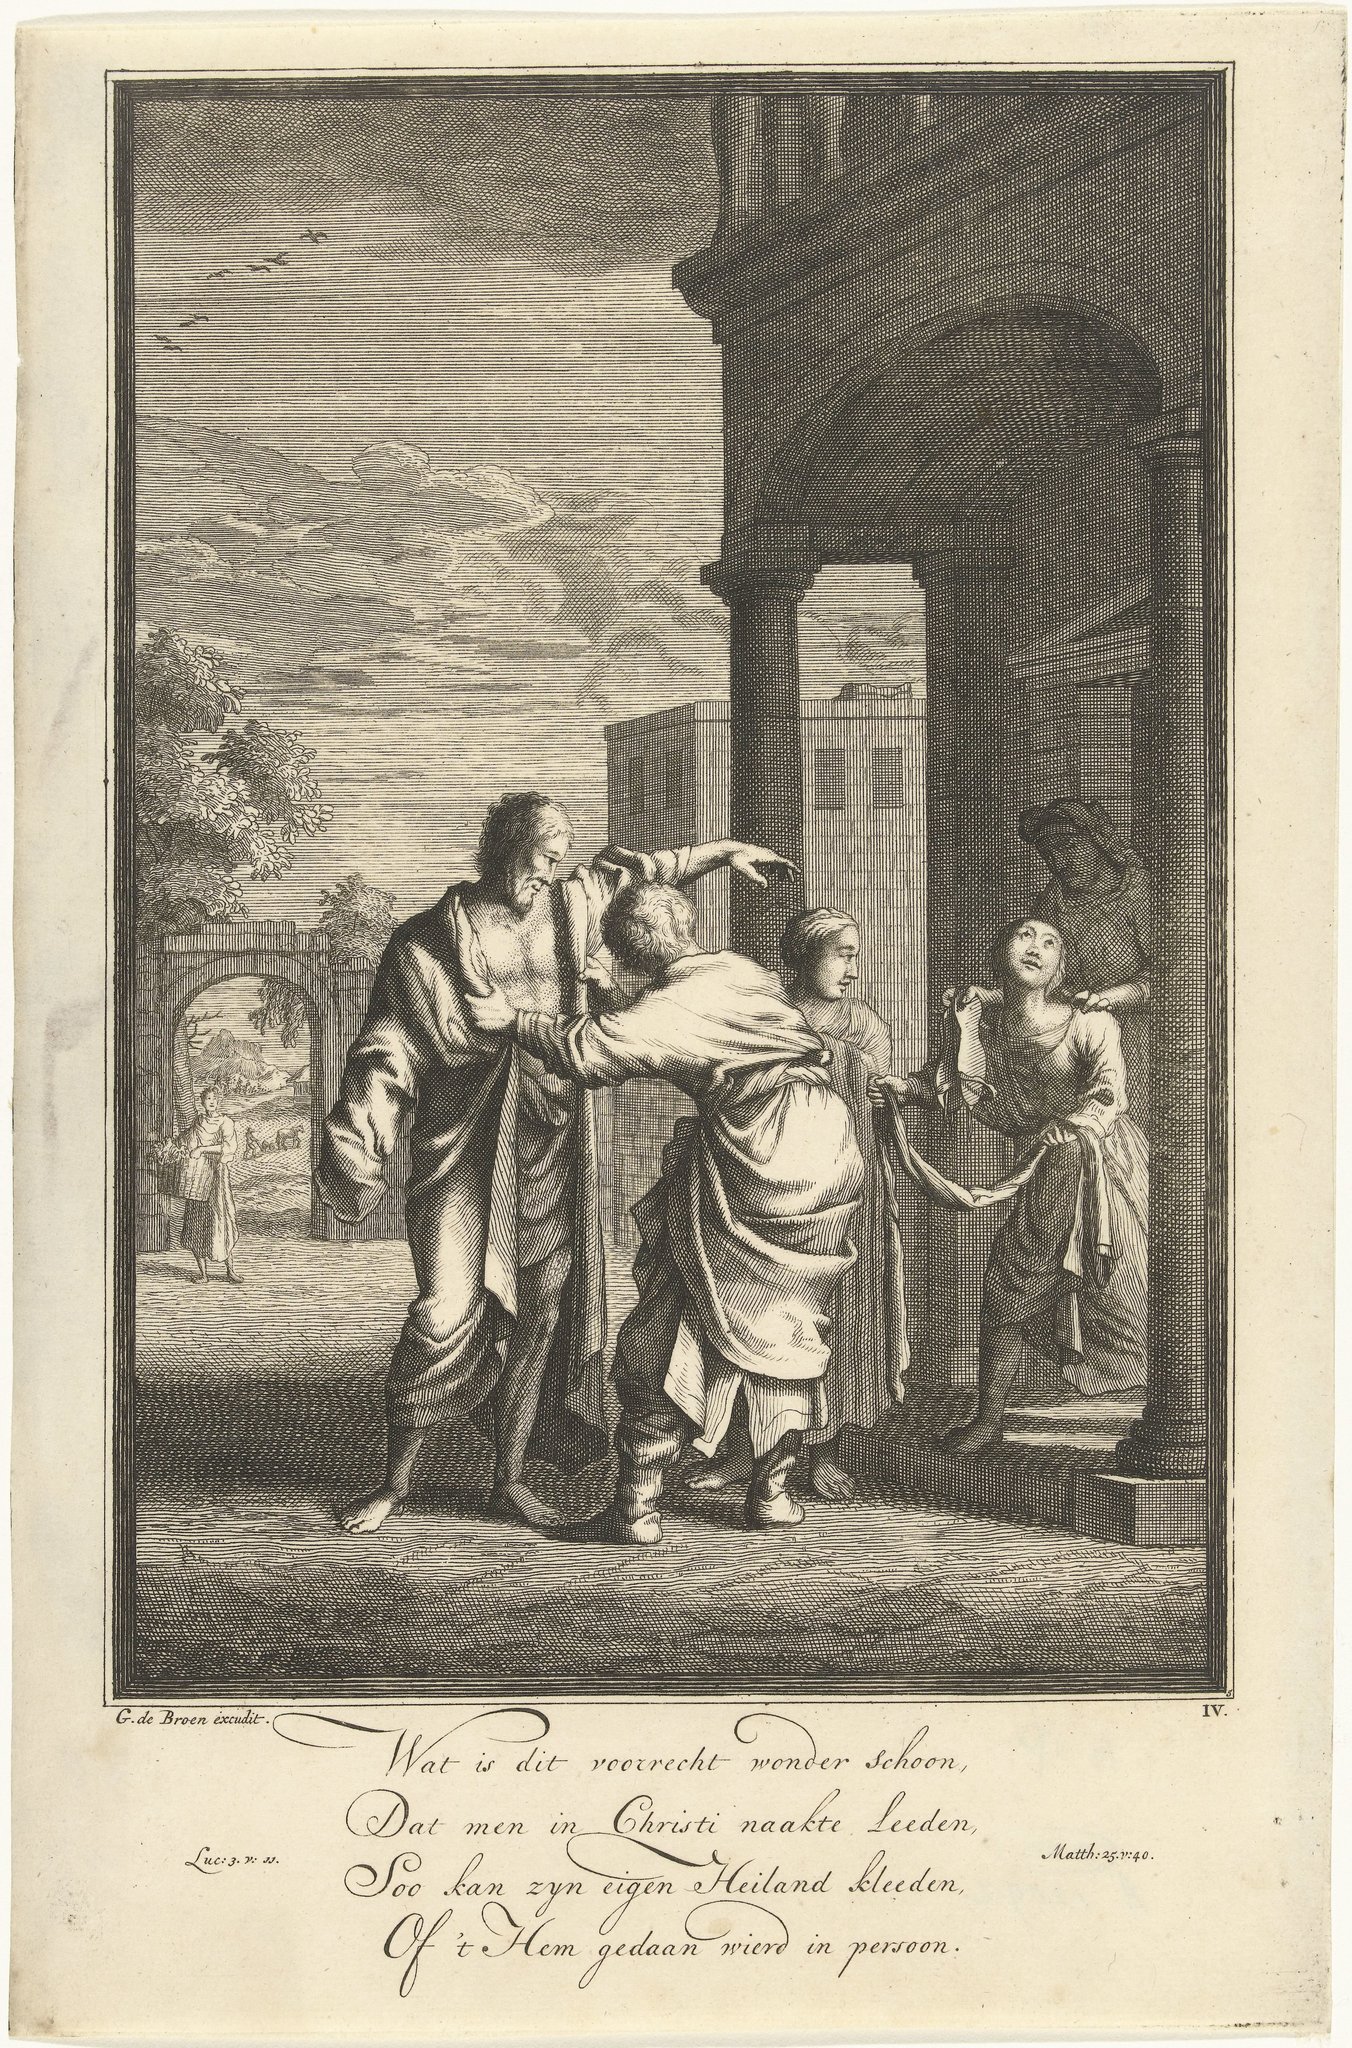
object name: print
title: Zeven werken van barmhartigheid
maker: gerrit de broen (i)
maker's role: print maker, publisher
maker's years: 1659-1740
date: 1695-1740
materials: paper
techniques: engraving, etching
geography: amsterdam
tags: clothing the naked, 'nudus vestitur' ~ one of the (seven) acts of mercy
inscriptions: collector's mark: Lugt 2228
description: Een man helpt de bedelaar in een jas. Een meisje brengt een das en een andere man komt met schoenen uit het huis gelopen. Onder de voorstelling een Nederlands vers over de werken van barmhartigheid.